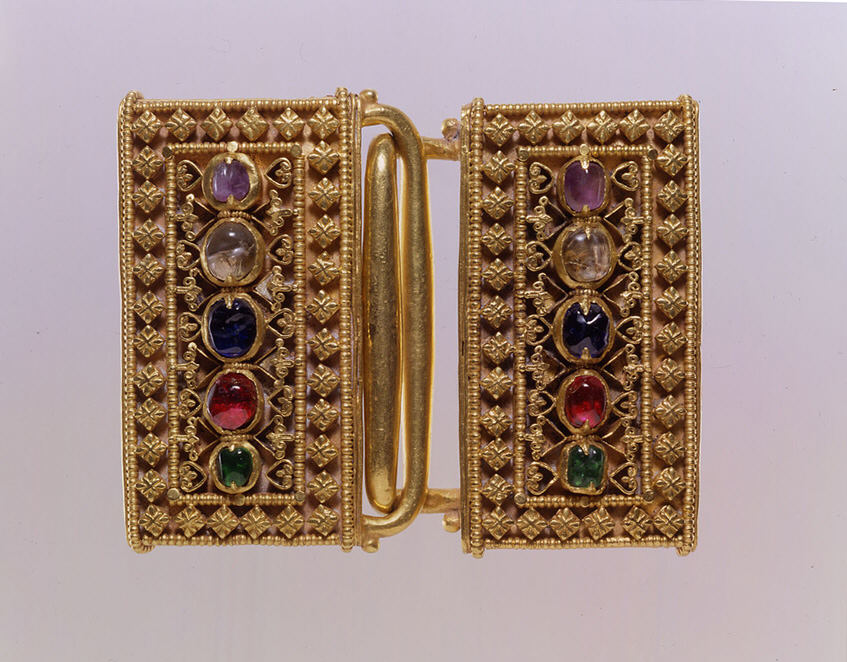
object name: buckle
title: Two-Part Buckle with Inlaid Stones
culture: indonesian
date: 1701-1900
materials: gold, stone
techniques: inlay